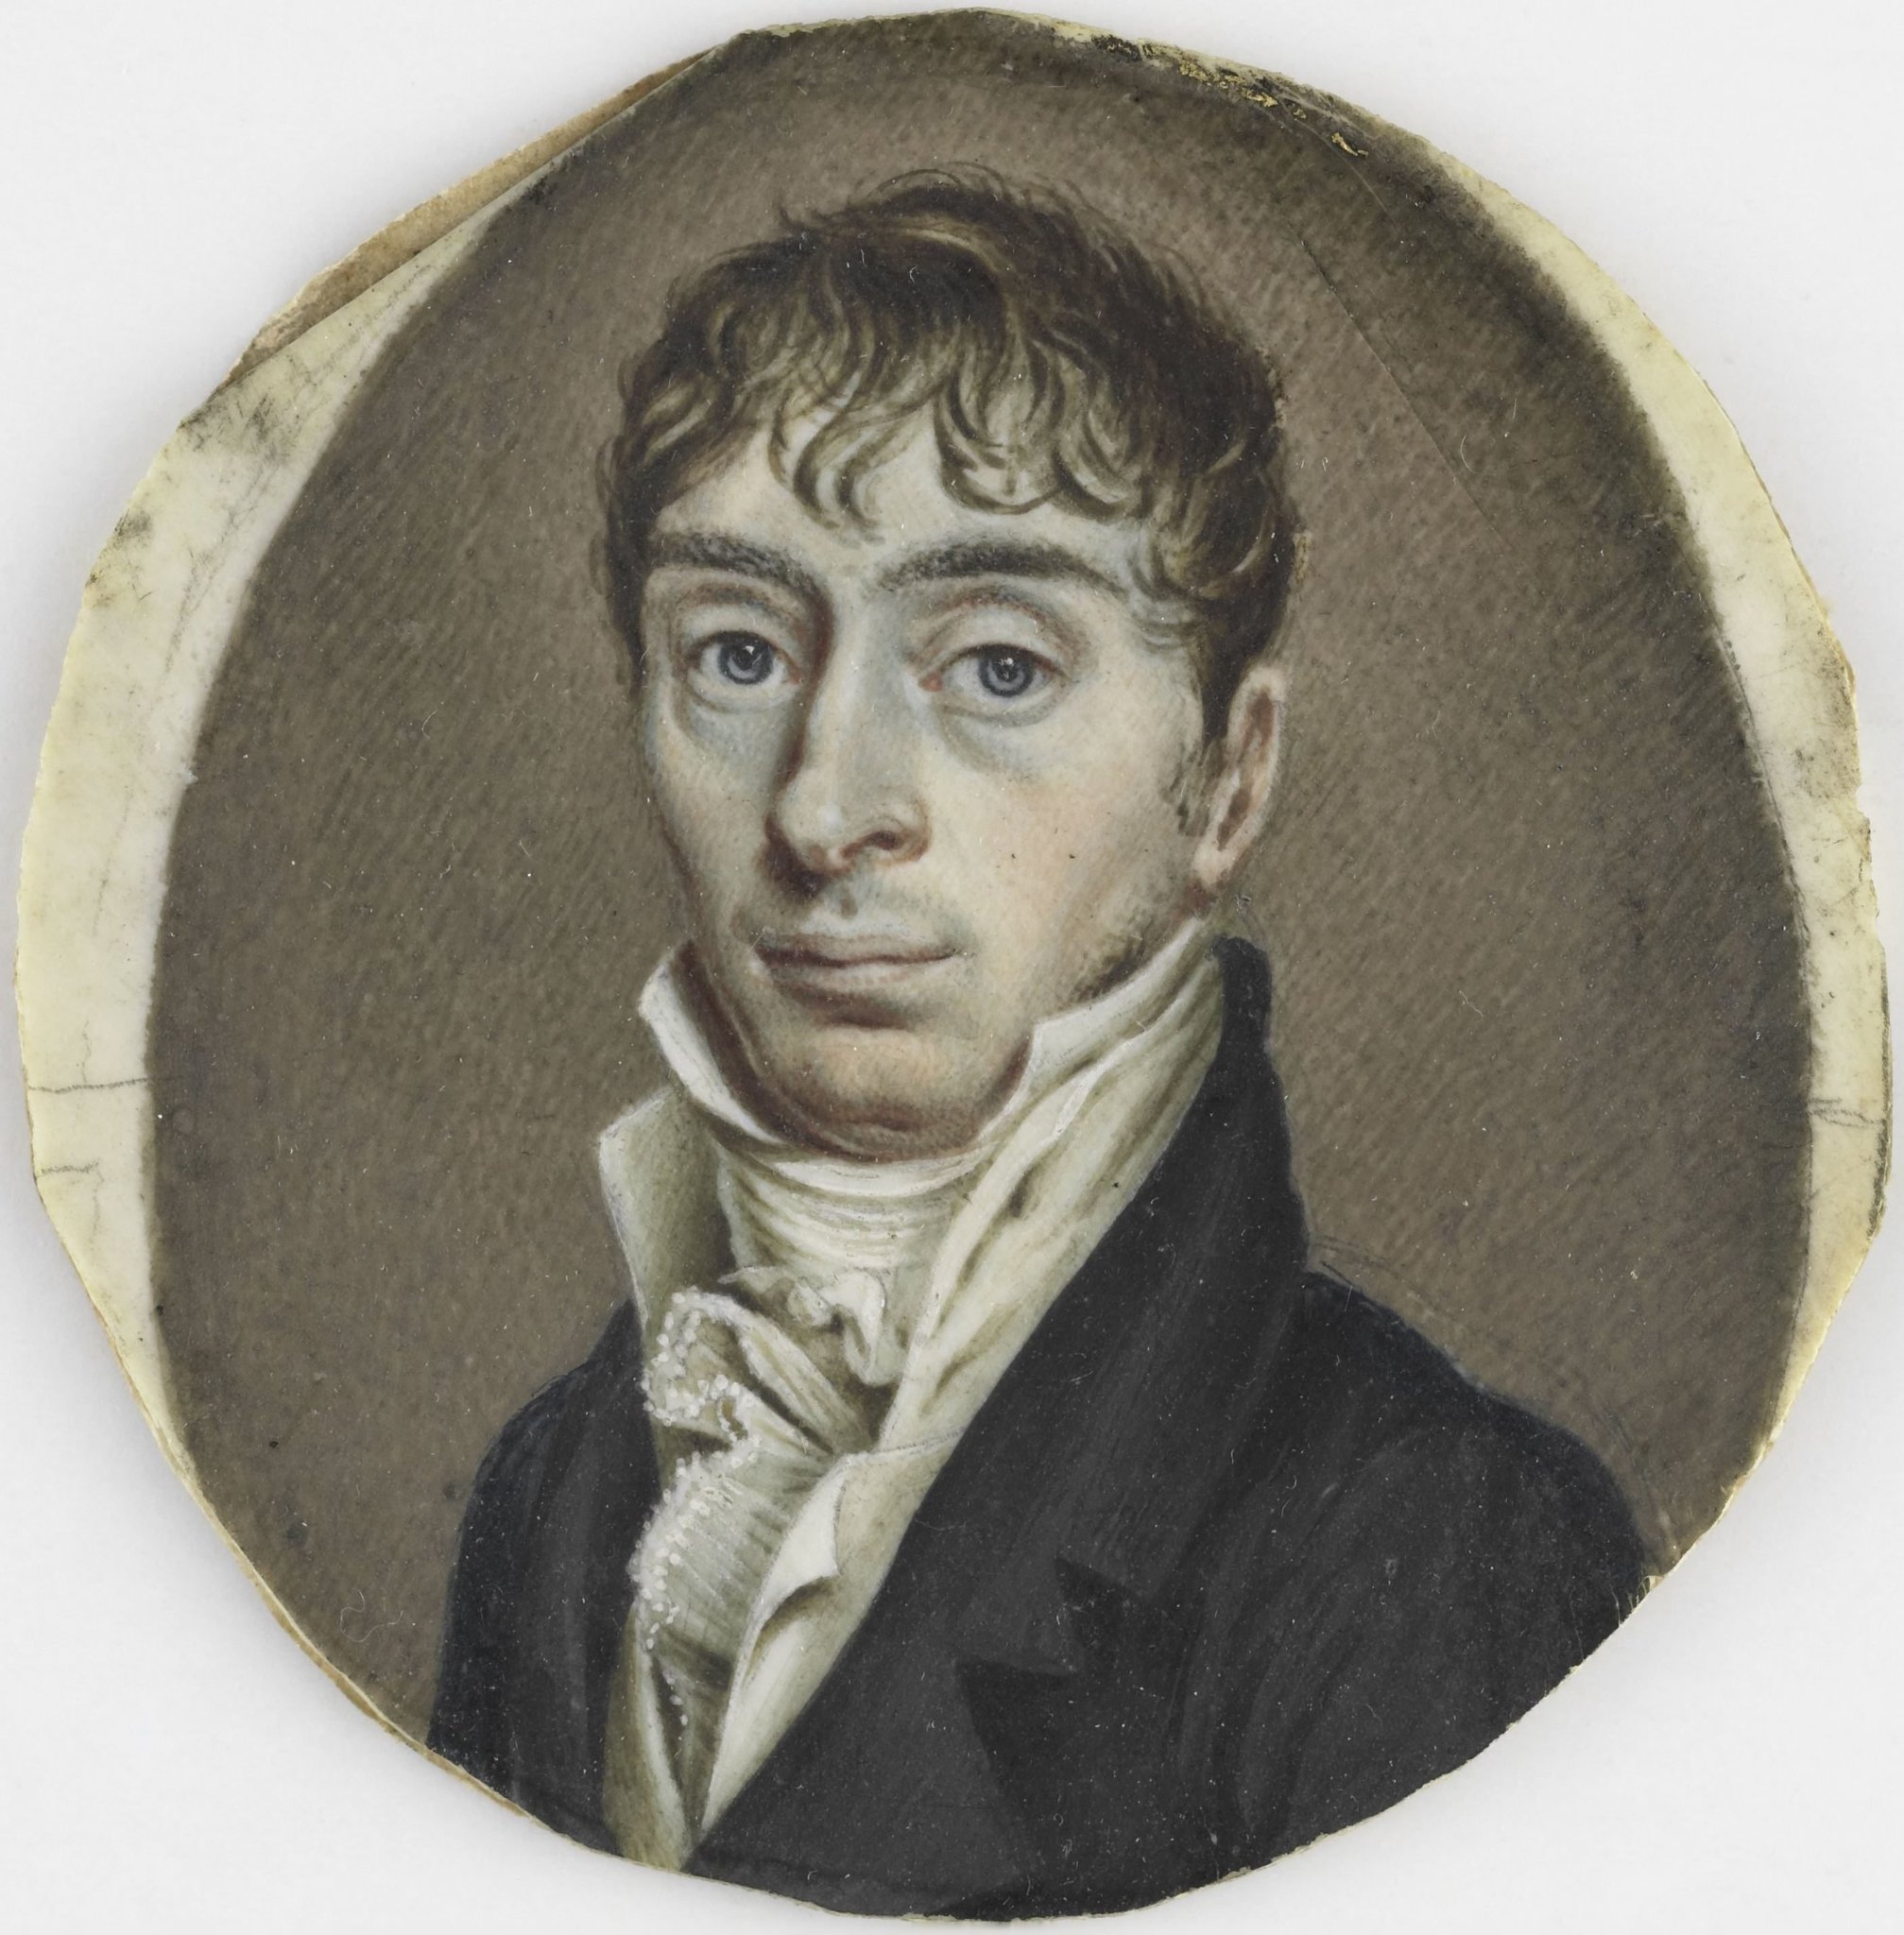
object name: painting, miniature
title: Portret van een onbekende man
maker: hendrik willem caspari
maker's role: draughtsman, print maker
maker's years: 1770-1829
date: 1785-1829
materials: glass, ivory, metal, wood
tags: historical persons not known by name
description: Hendrik Willem Caspari, 1770 - 1820. Portrait of an unknown man. Ivory.